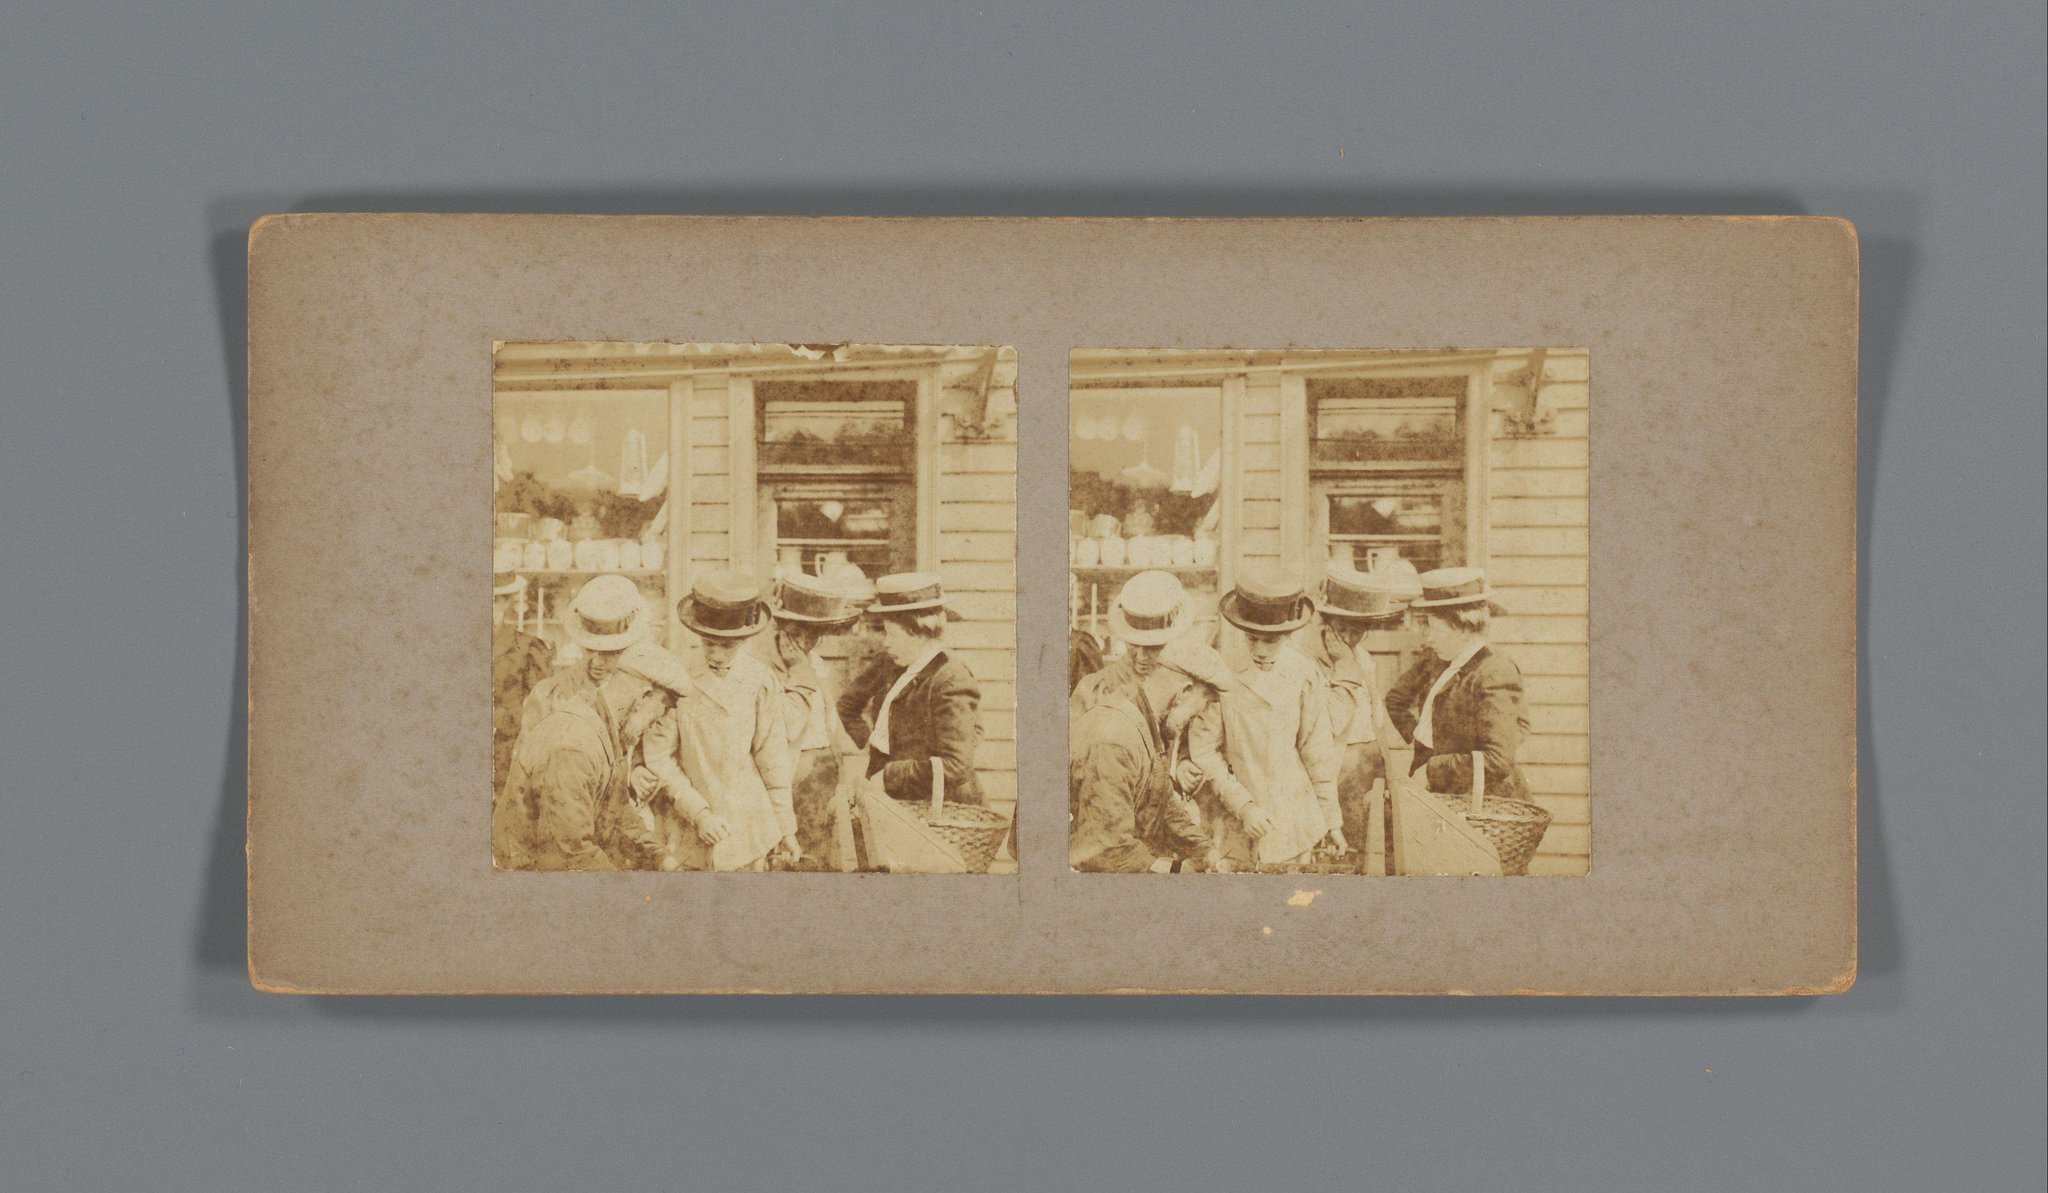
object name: stereograph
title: Vischmarkt, Bergen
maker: Anonymous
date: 1882-1890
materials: cardboard, photographic support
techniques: gelatin silver print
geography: bergen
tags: street, shop-window, show-window